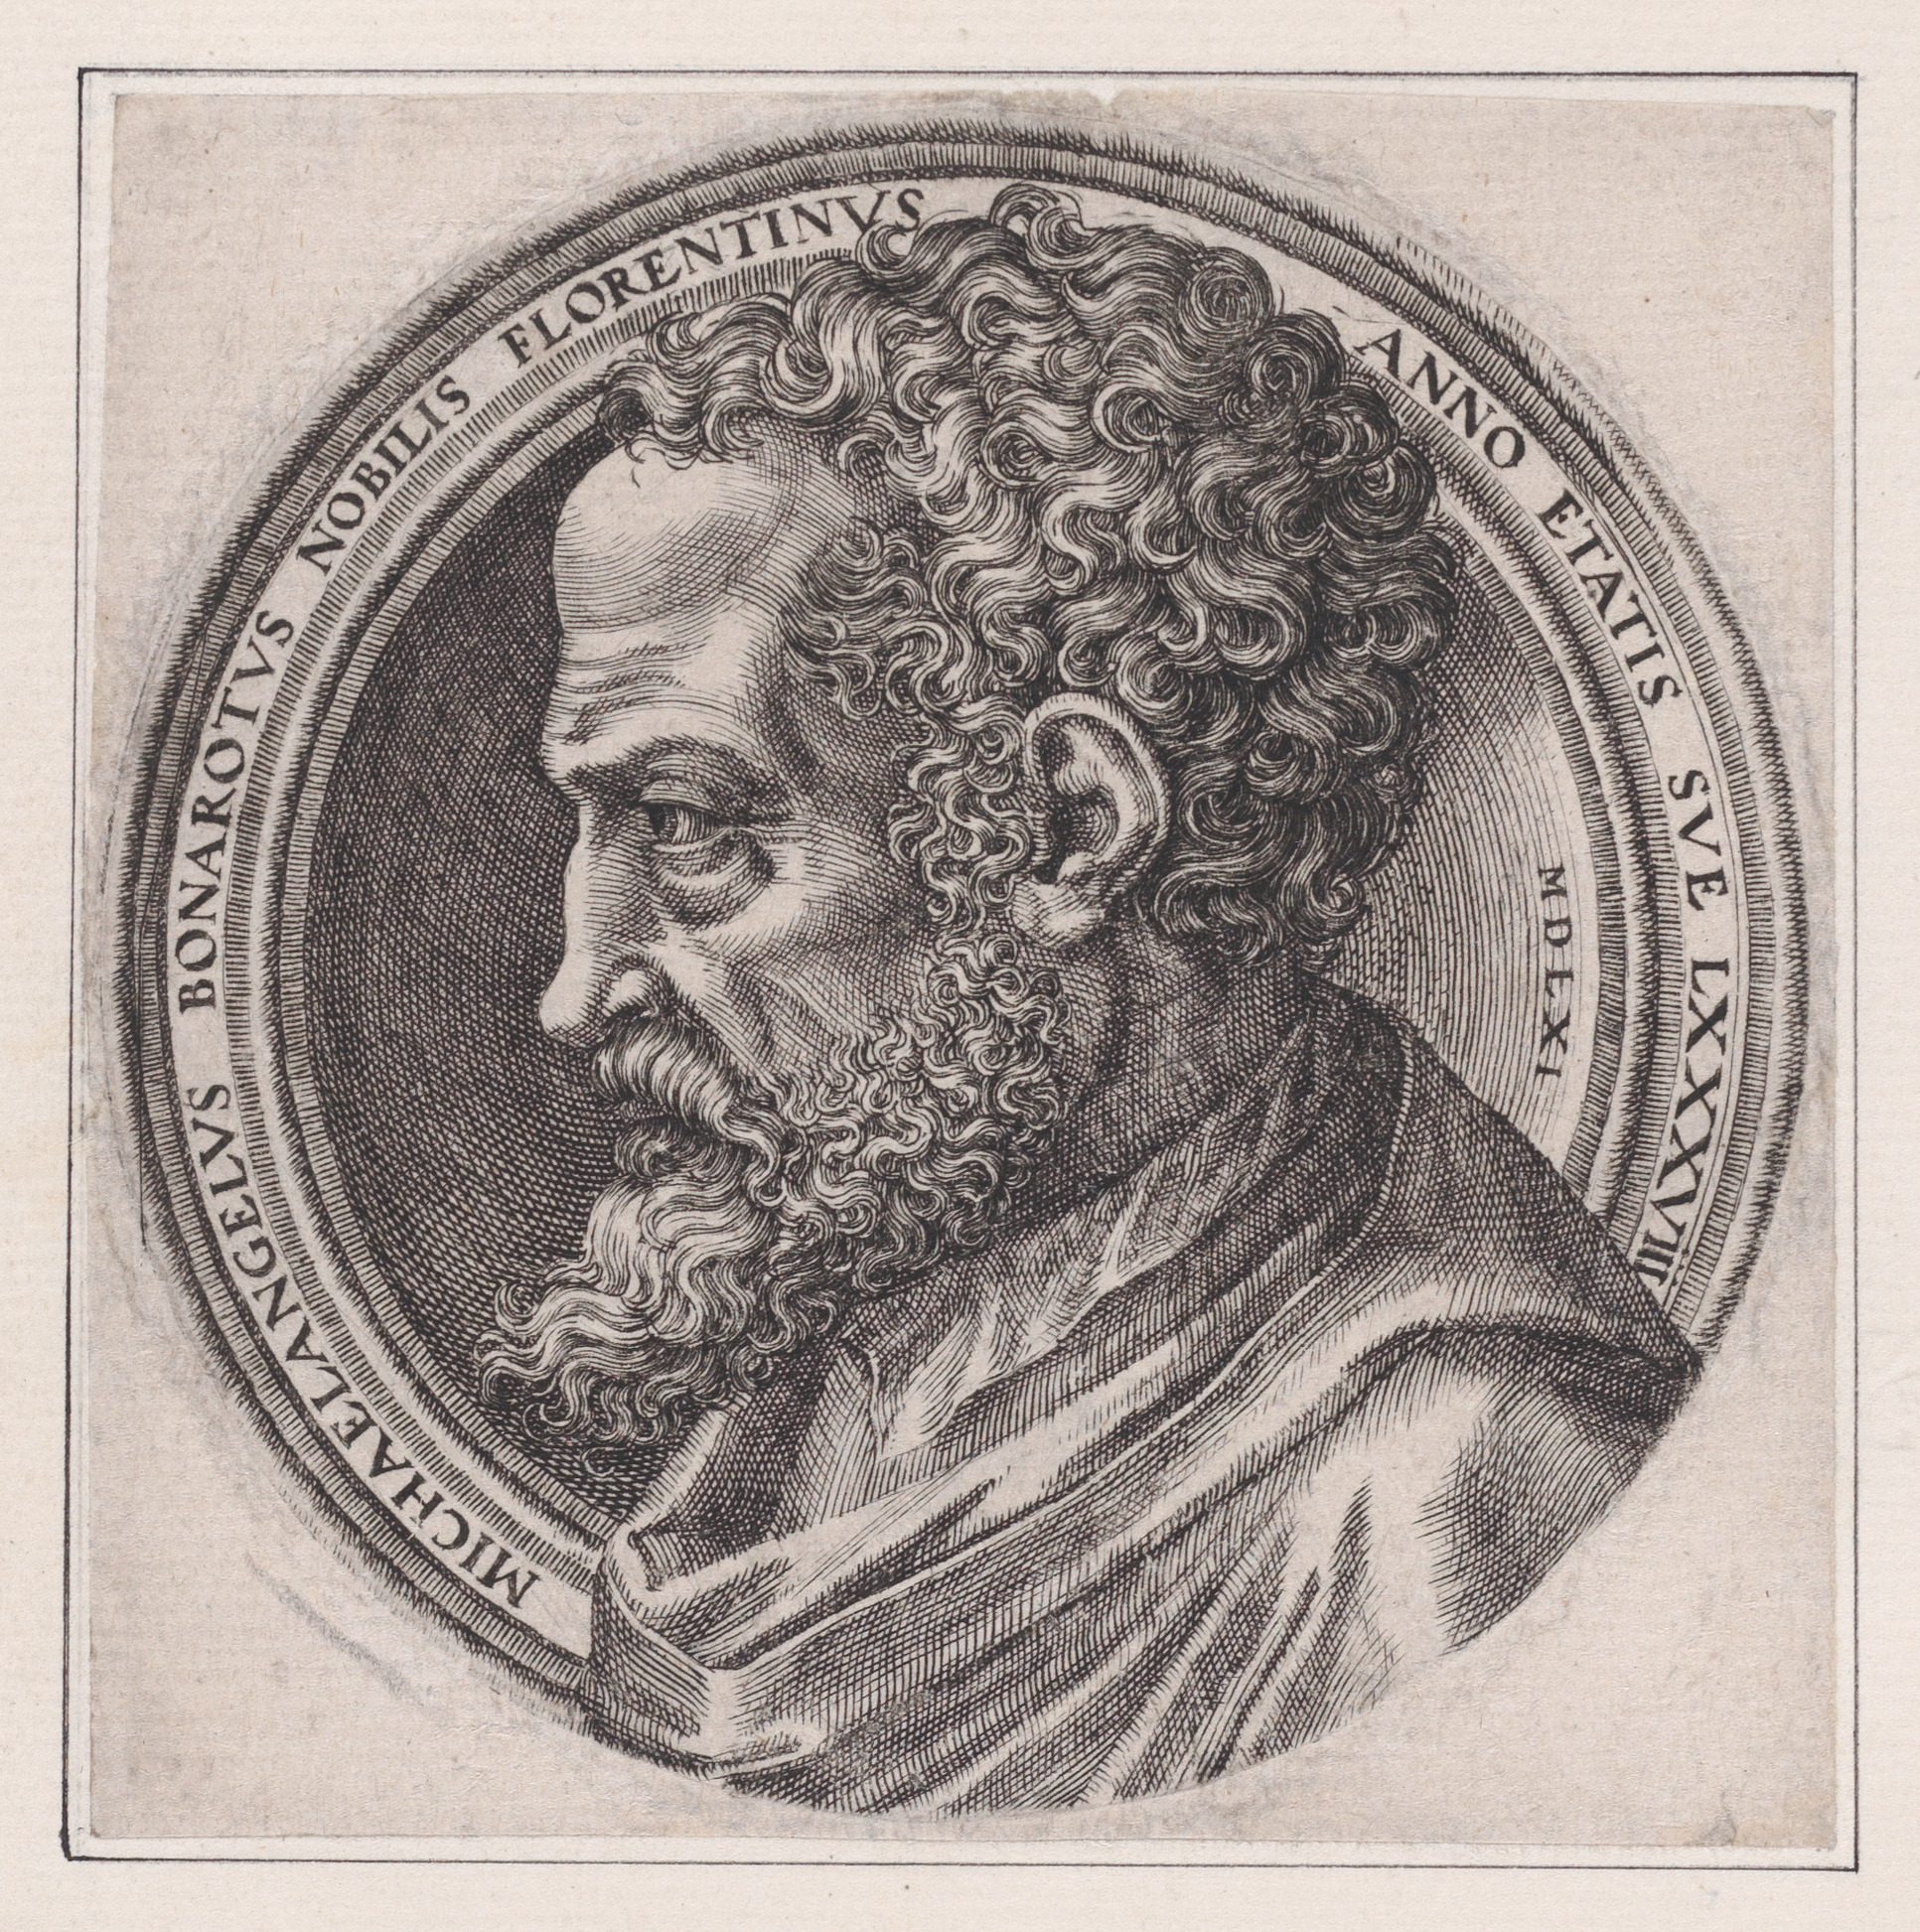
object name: print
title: Michelangelo Buonarroti (?)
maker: lambert suavius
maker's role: artist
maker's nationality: netherlandish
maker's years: 1510-1576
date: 1530-1576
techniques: engraving